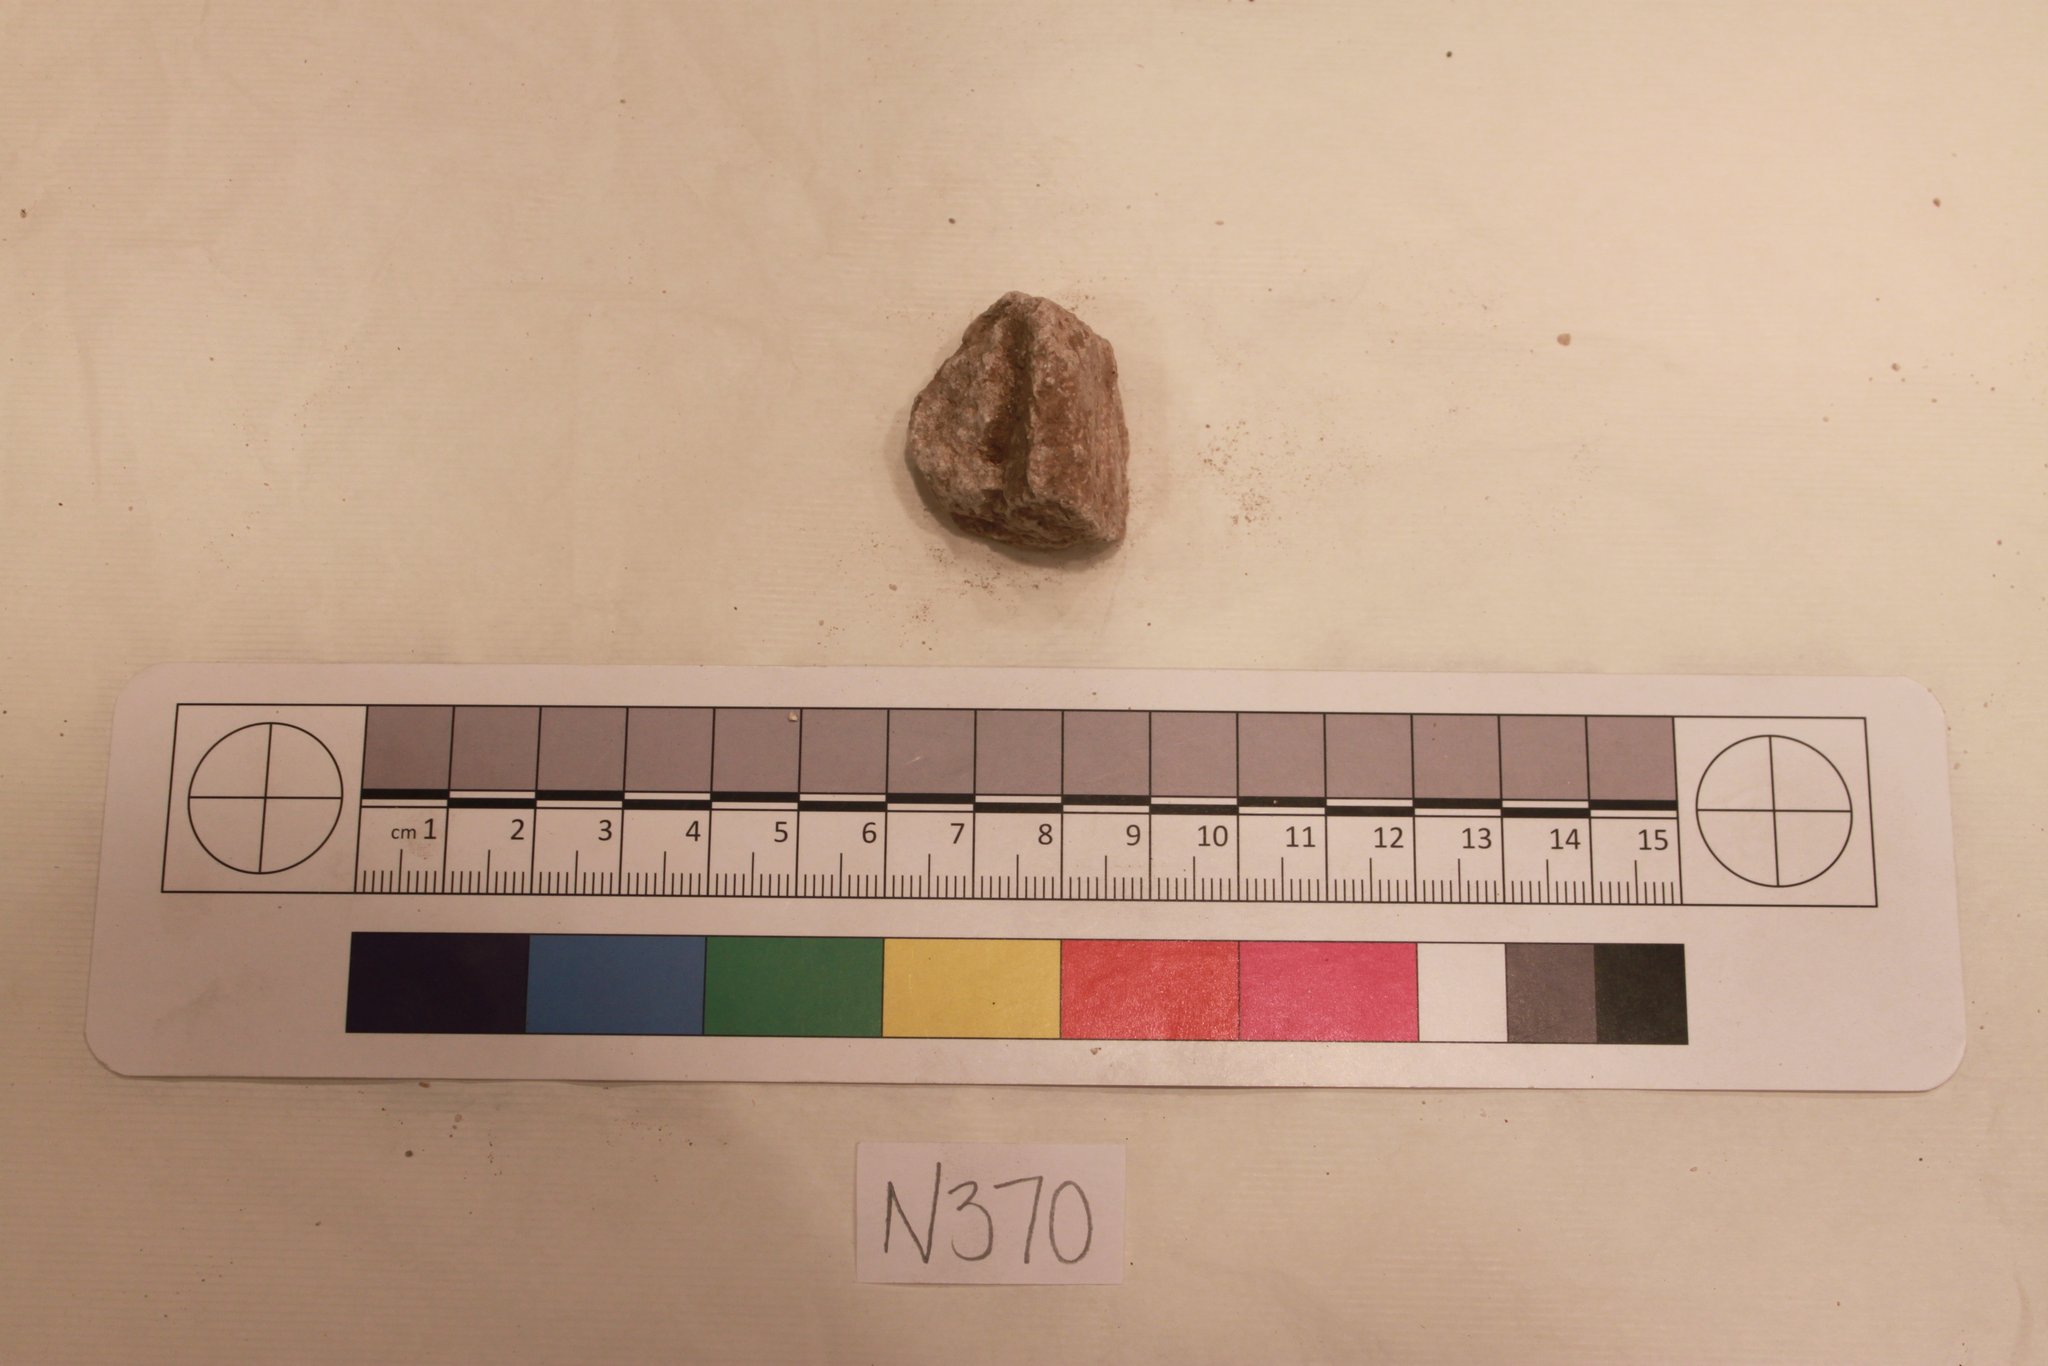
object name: fragment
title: Stucco Fragment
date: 701-1200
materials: plaster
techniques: carving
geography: iran